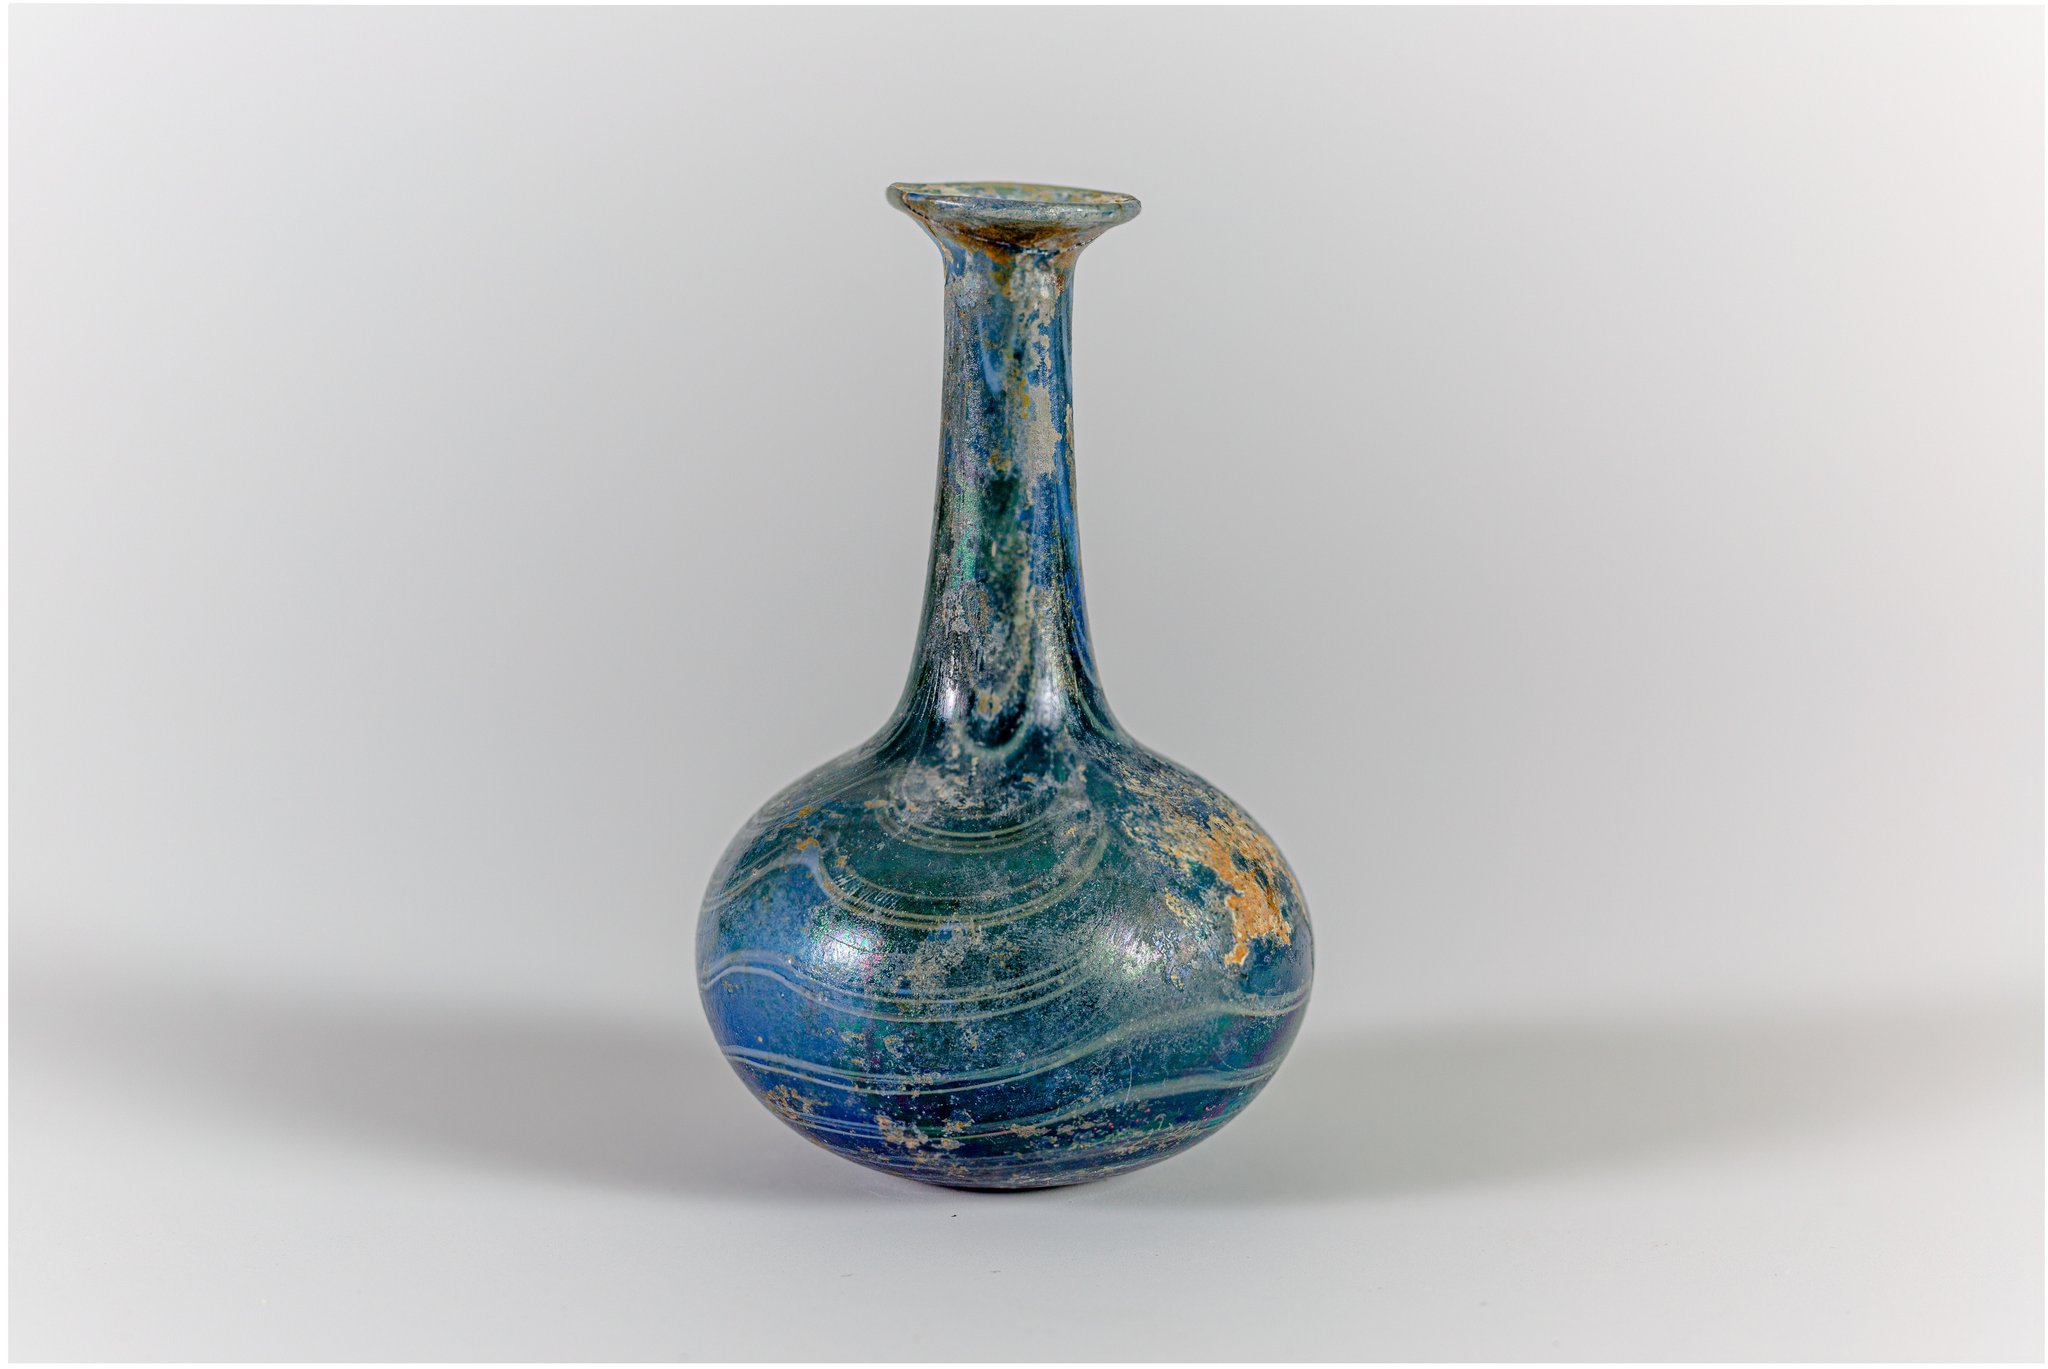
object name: perfume bottle, marbled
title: Glass perfume bottle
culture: roman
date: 1-100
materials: glass